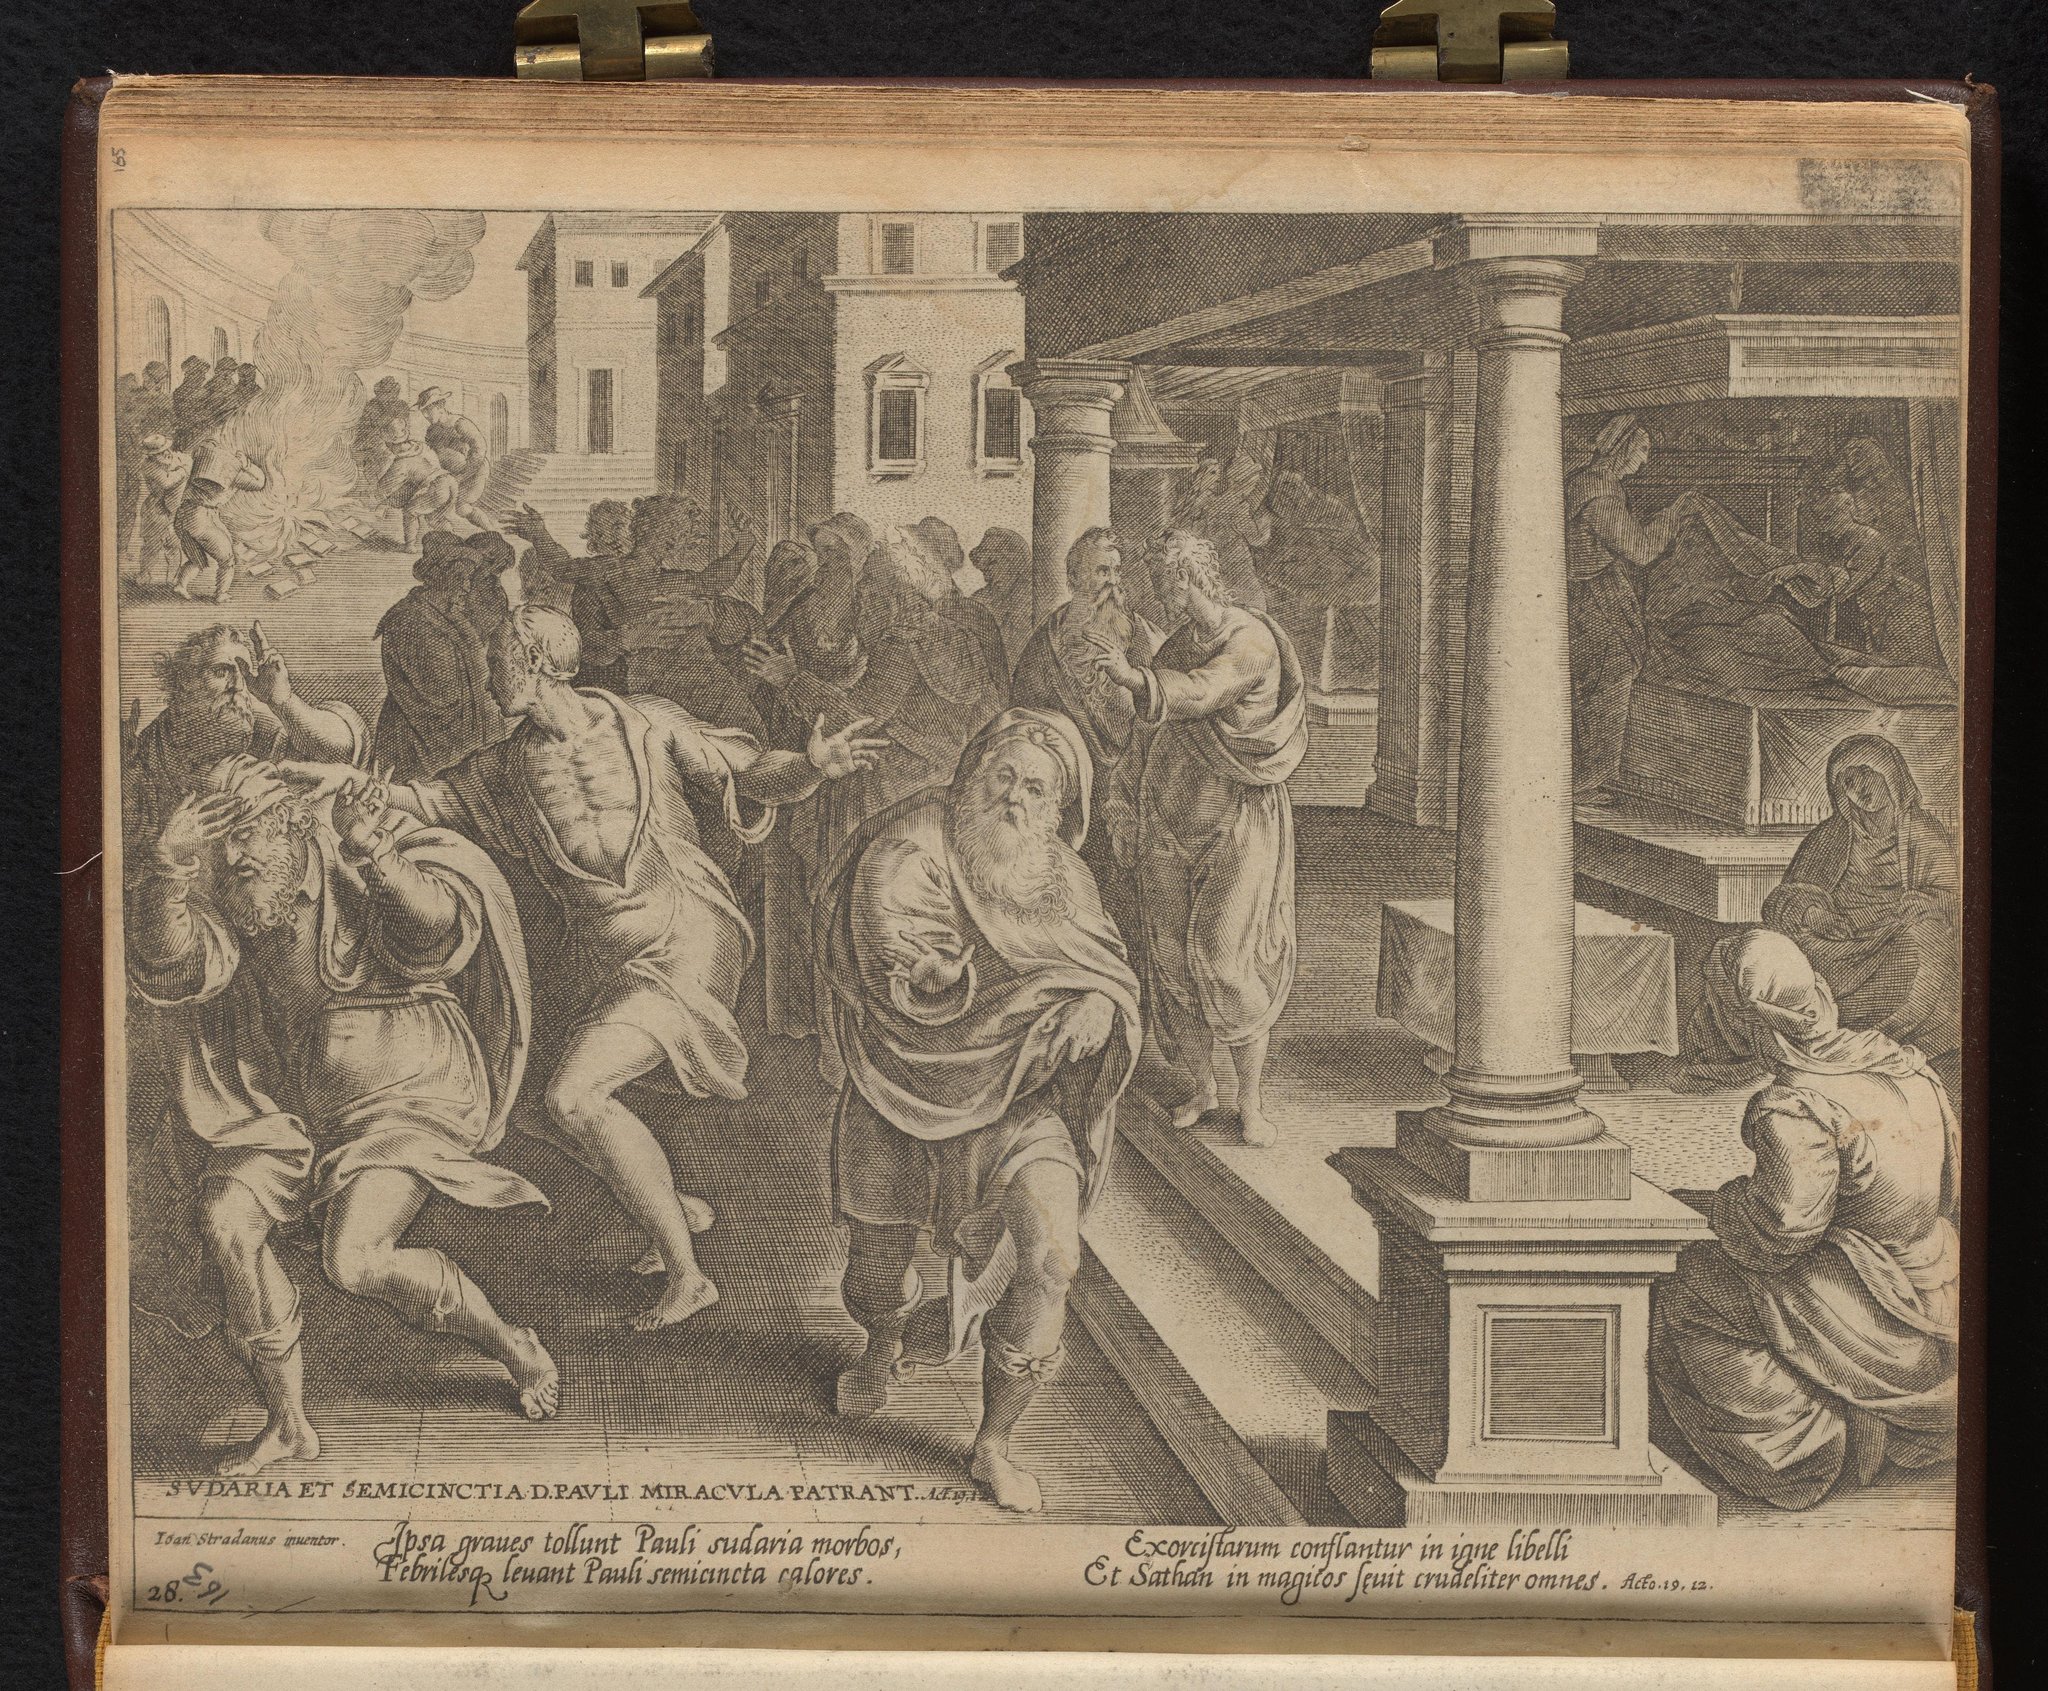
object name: album leaf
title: Acta Apostolorum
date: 1582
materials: paper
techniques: engraving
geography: antwerp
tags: the ephesians burn the exorcists' books in public, seven exorcists, sons of sceva, are beaten by a man with an evil spirit, and flee, paul's handkerchiefs and aprons cure the sick and possessed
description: Prent maakt deel uit van een prentbijbel.